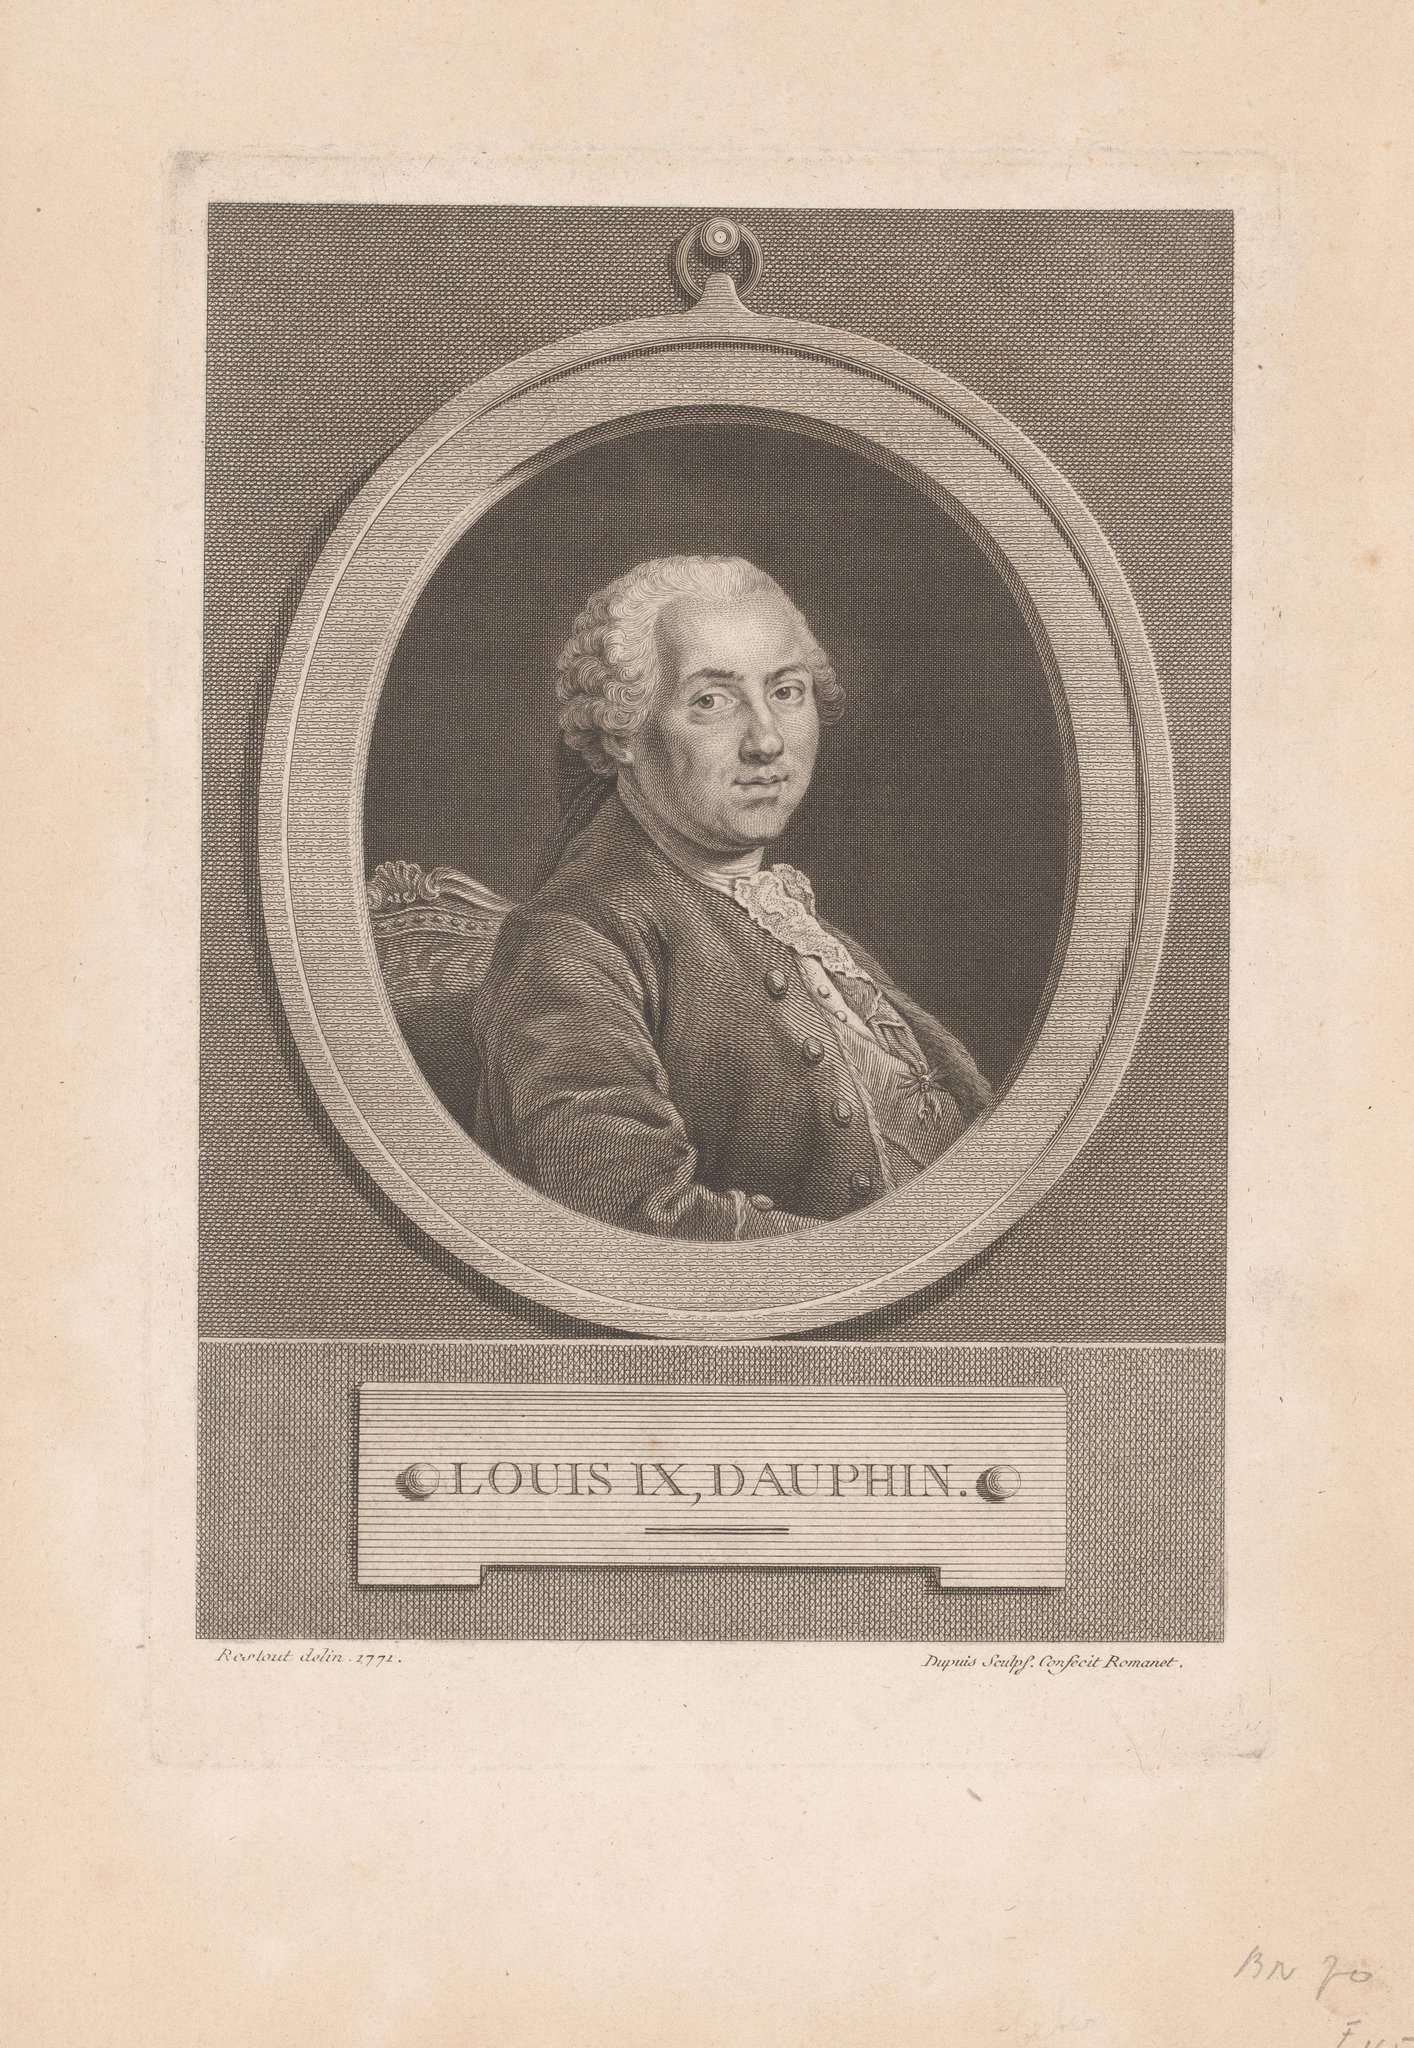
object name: print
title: Portret van Lodewijk van Frankrijk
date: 1771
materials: paper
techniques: engraving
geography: france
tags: lodewijk van frankrijk (dauphin van frankrijk), ornament ~ medallion, historical persons, ruler, sovereign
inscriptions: collector's mark: Lugt 2228